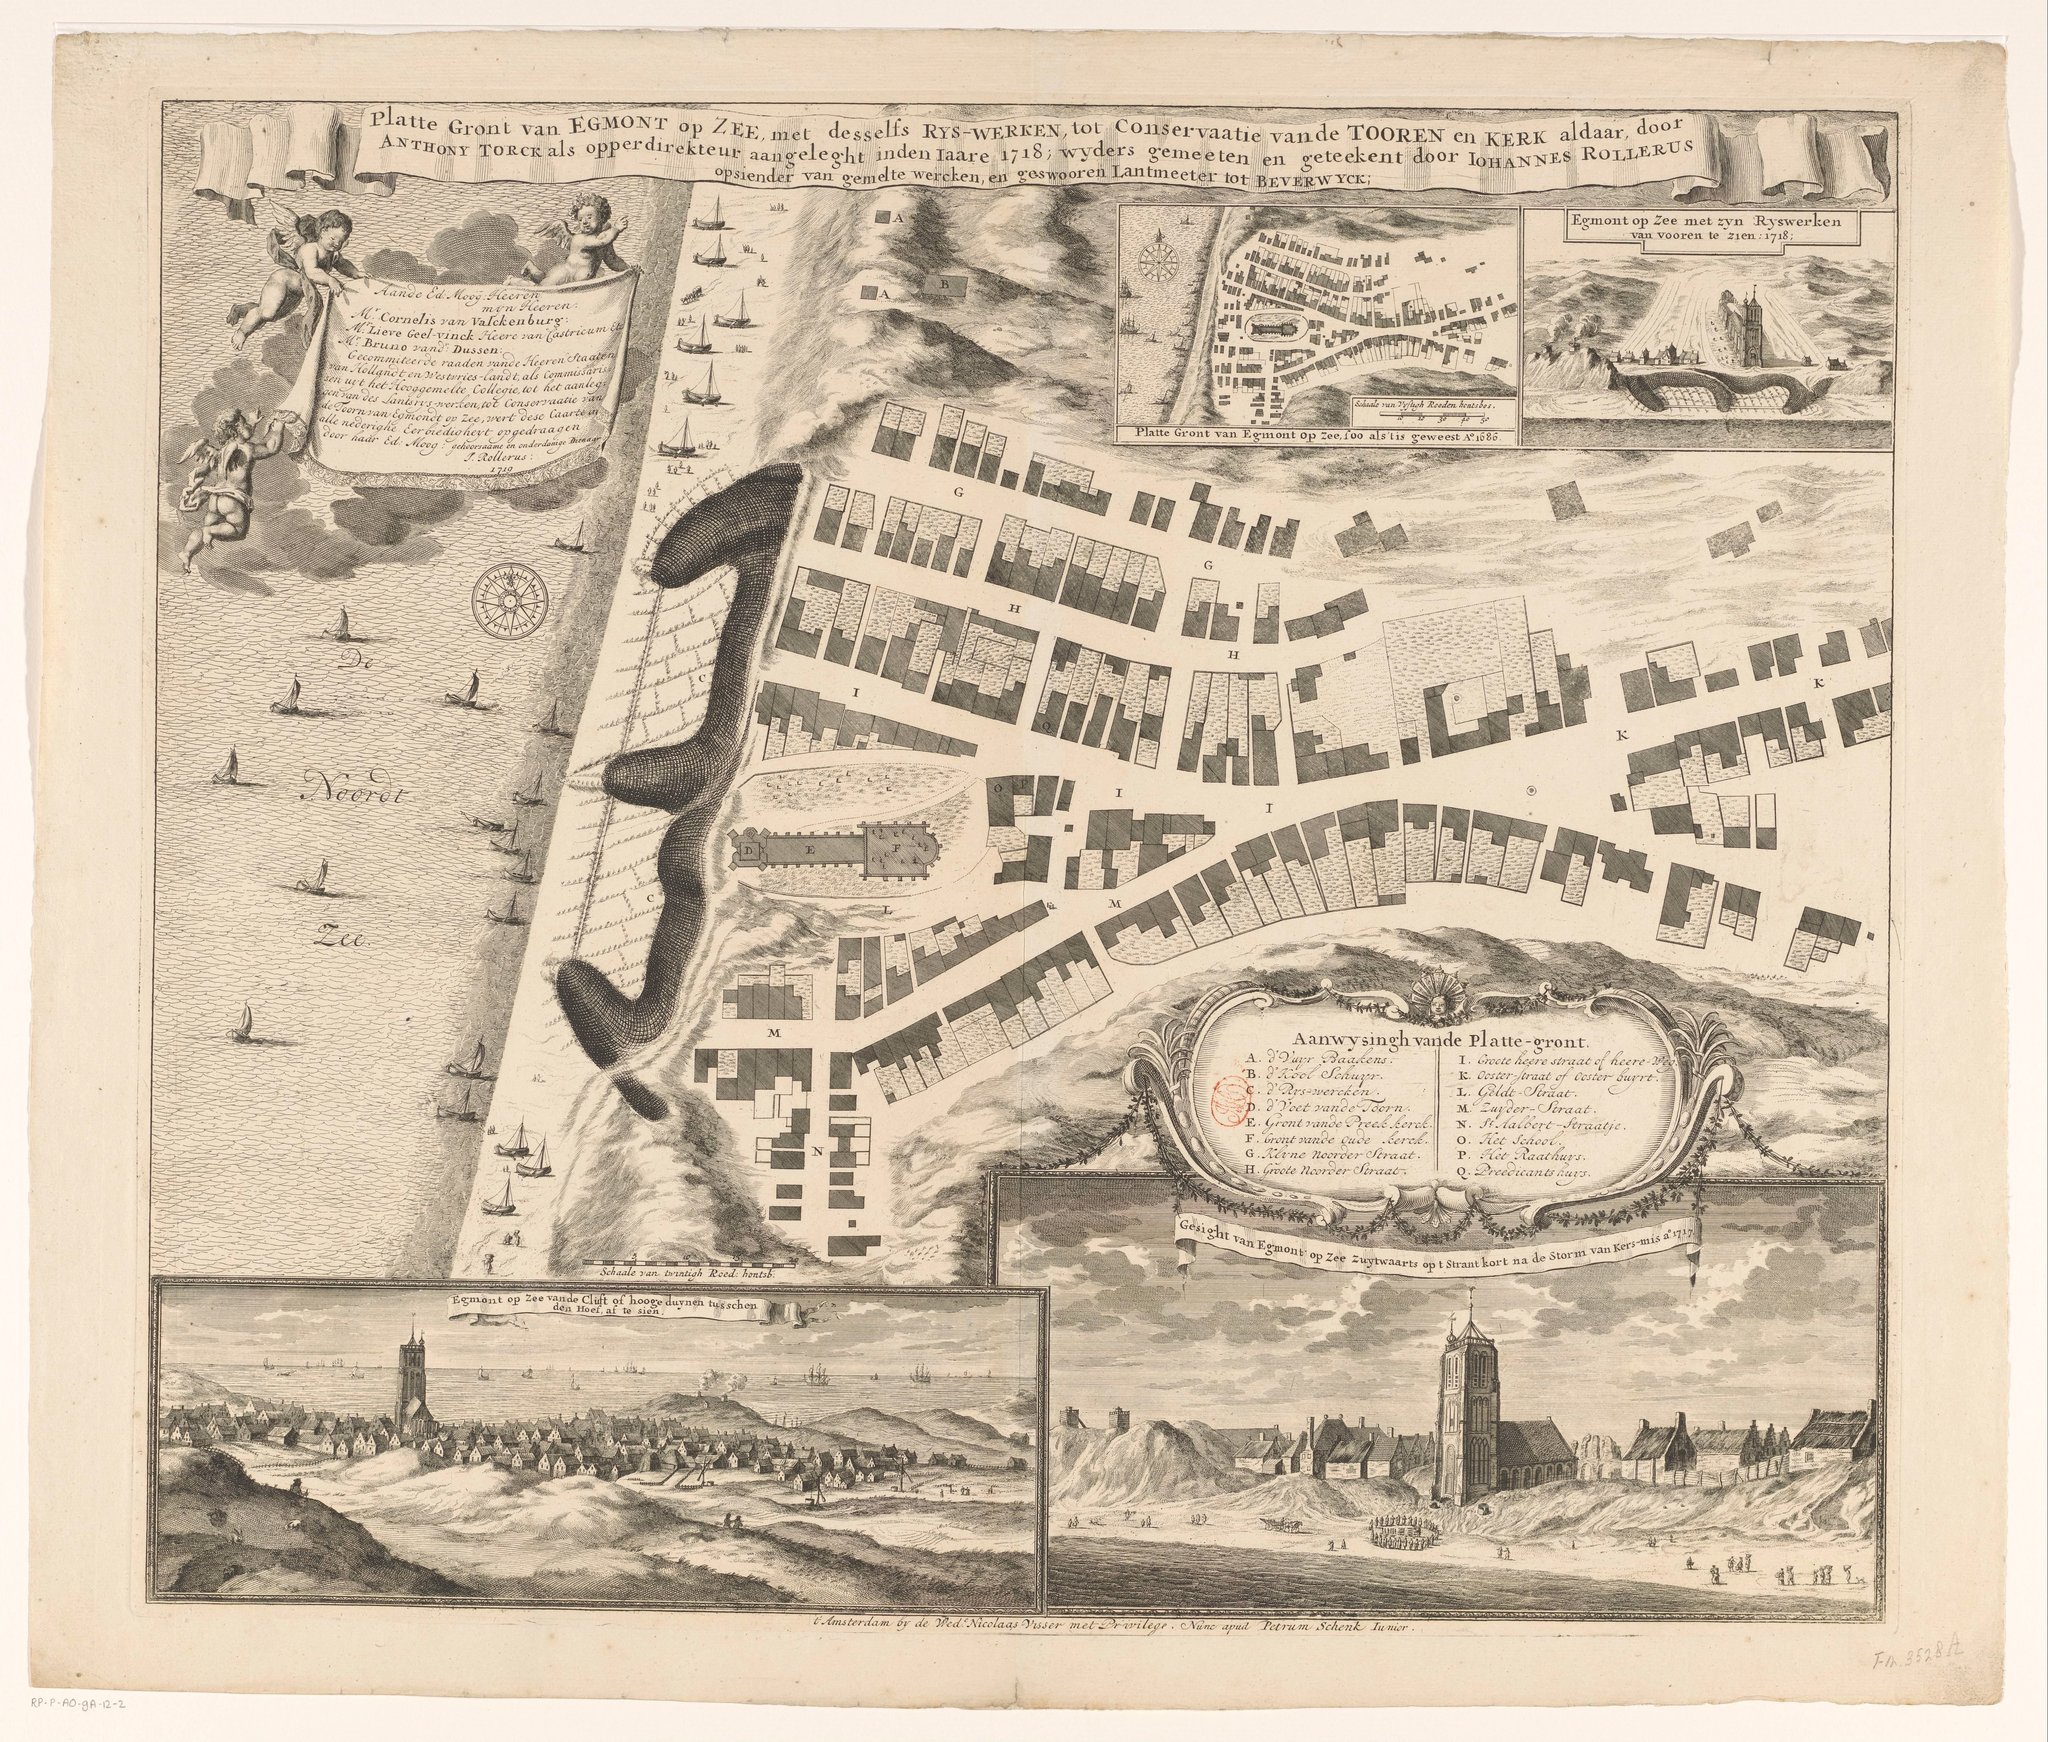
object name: print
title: Plattegrond van Egmond aan Zee met beschermingswerken, 1718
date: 1719-1726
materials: paper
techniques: engraving, etching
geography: beverwijk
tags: prospect of village, silhouette of village, dune coast, coastal protection work, breakwater, storm, maps of cities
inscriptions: collector's mark: Lugt 195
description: Plattegrond van Egmond aan Zee met de in 1718 aangebrachte beschermingswerken aan de kust. Rond Kerstmis 1717 had een storm de duinen grotendeels verwoest waardoor de kerk bijna op het strand kwam te liggen, in 1718 werden daarom maatregelen genomen om de kerk en het dorp te beschermen. De grote plattegrond met een legenda A-Q staat centraal. Linksonder op deze plattegrond een schaalstok: Schaale van twintigh roed: Hontb:. Langs de bovenkant de titel, links daaronder een cartouche met de opdracht. Rechtsboven een plattegrond van Egmond aan Zee in 1686 met een eigen schaalstok: Schaale van vyftigh roeden Hontsbos. Daarnaast een gezicht op het dorp met de beschermingswerken in 1718, gezien vanaf de zee. Linksonder een gezicht op het dorp gezien vanaf de duinen tussen Egmond aan Zee en Egmond aan den Hoef. Rechtsonder een gezicht op Egmond aan Zee gezien vanaf de zee vlak na de storm van 1717.